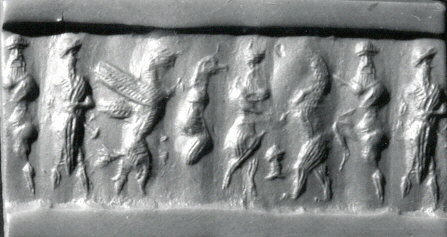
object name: cylinder seal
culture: babylonian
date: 1900-1501 BCE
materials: mineral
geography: mesopotamia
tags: animals,men